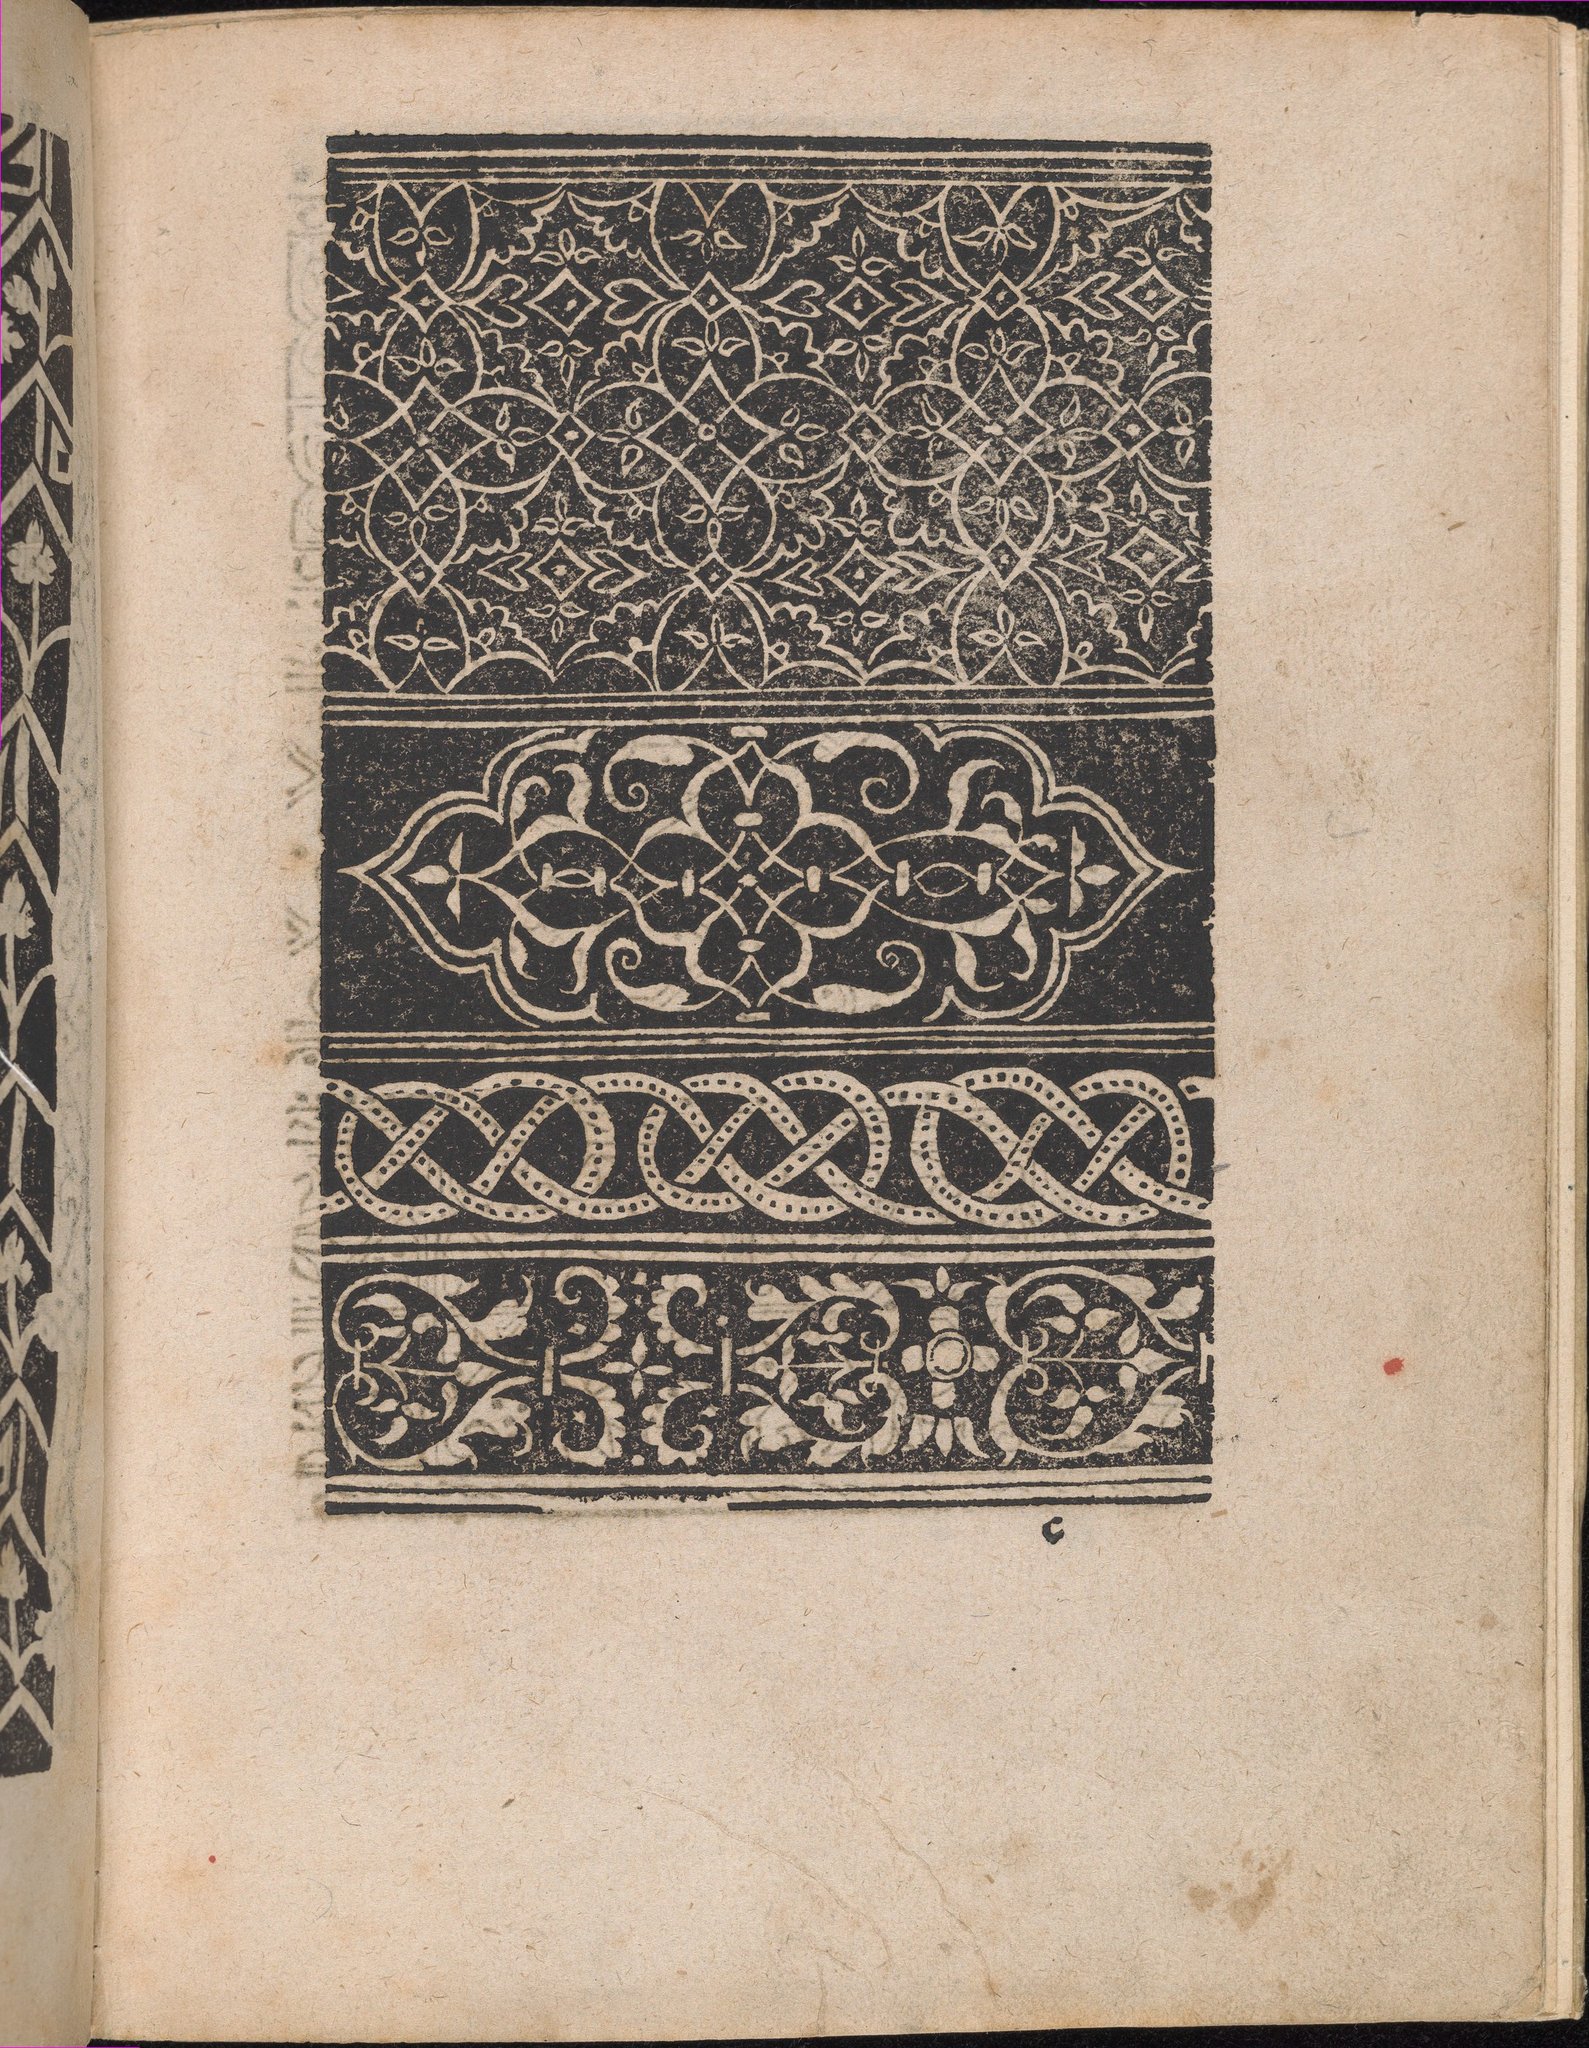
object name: book print ornament architecture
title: Modelbuch aller Art Nehens vn Stickens (Page 9r)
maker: christian egenolff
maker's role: publisher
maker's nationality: german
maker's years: 1502-1555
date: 1535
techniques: woodcut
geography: germany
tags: ornament